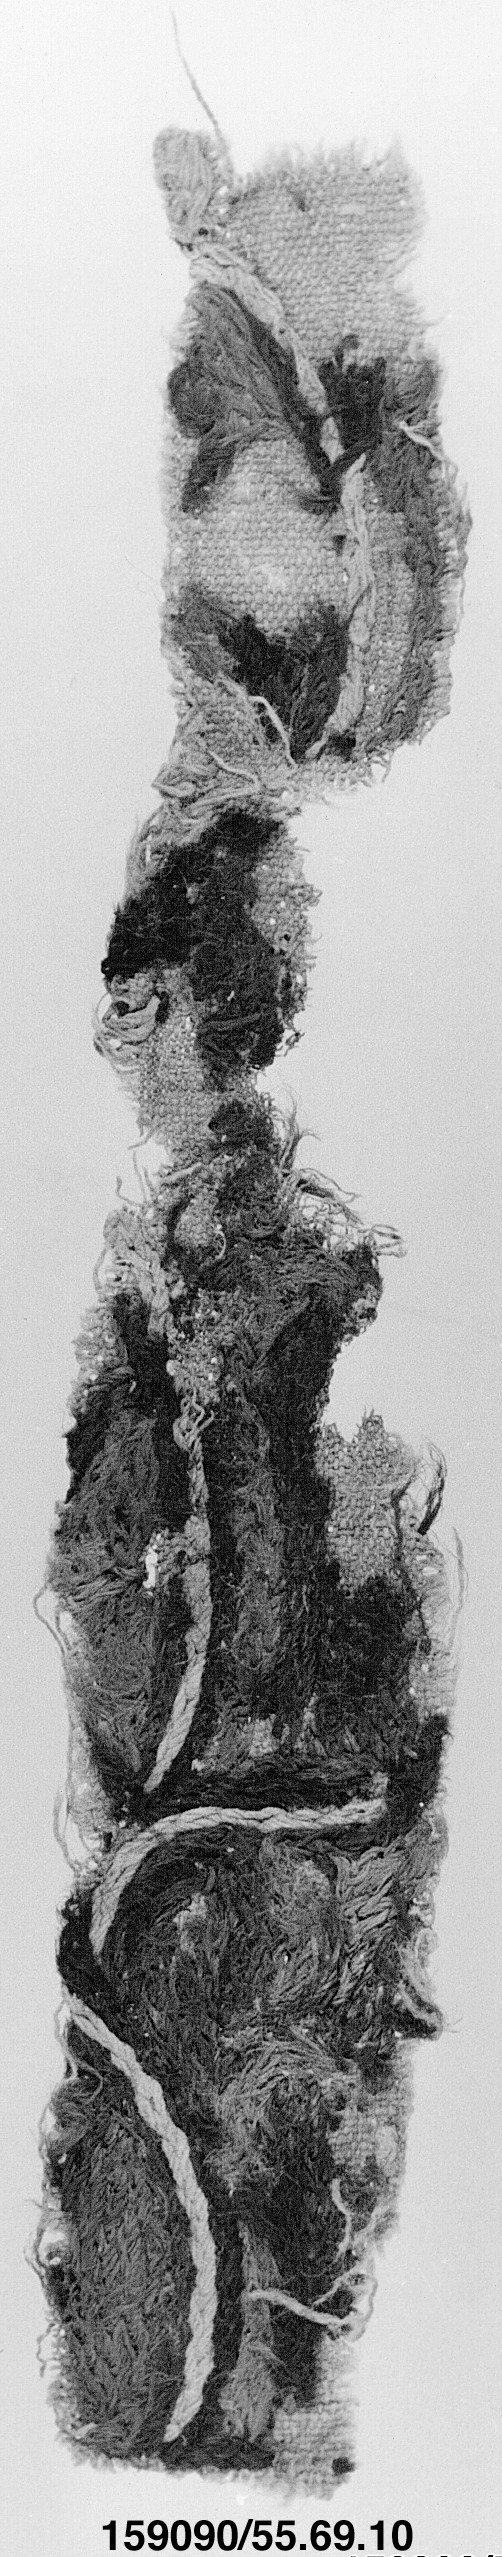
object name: textile fragment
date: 701-900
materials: wool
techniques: embroidery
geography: egypt